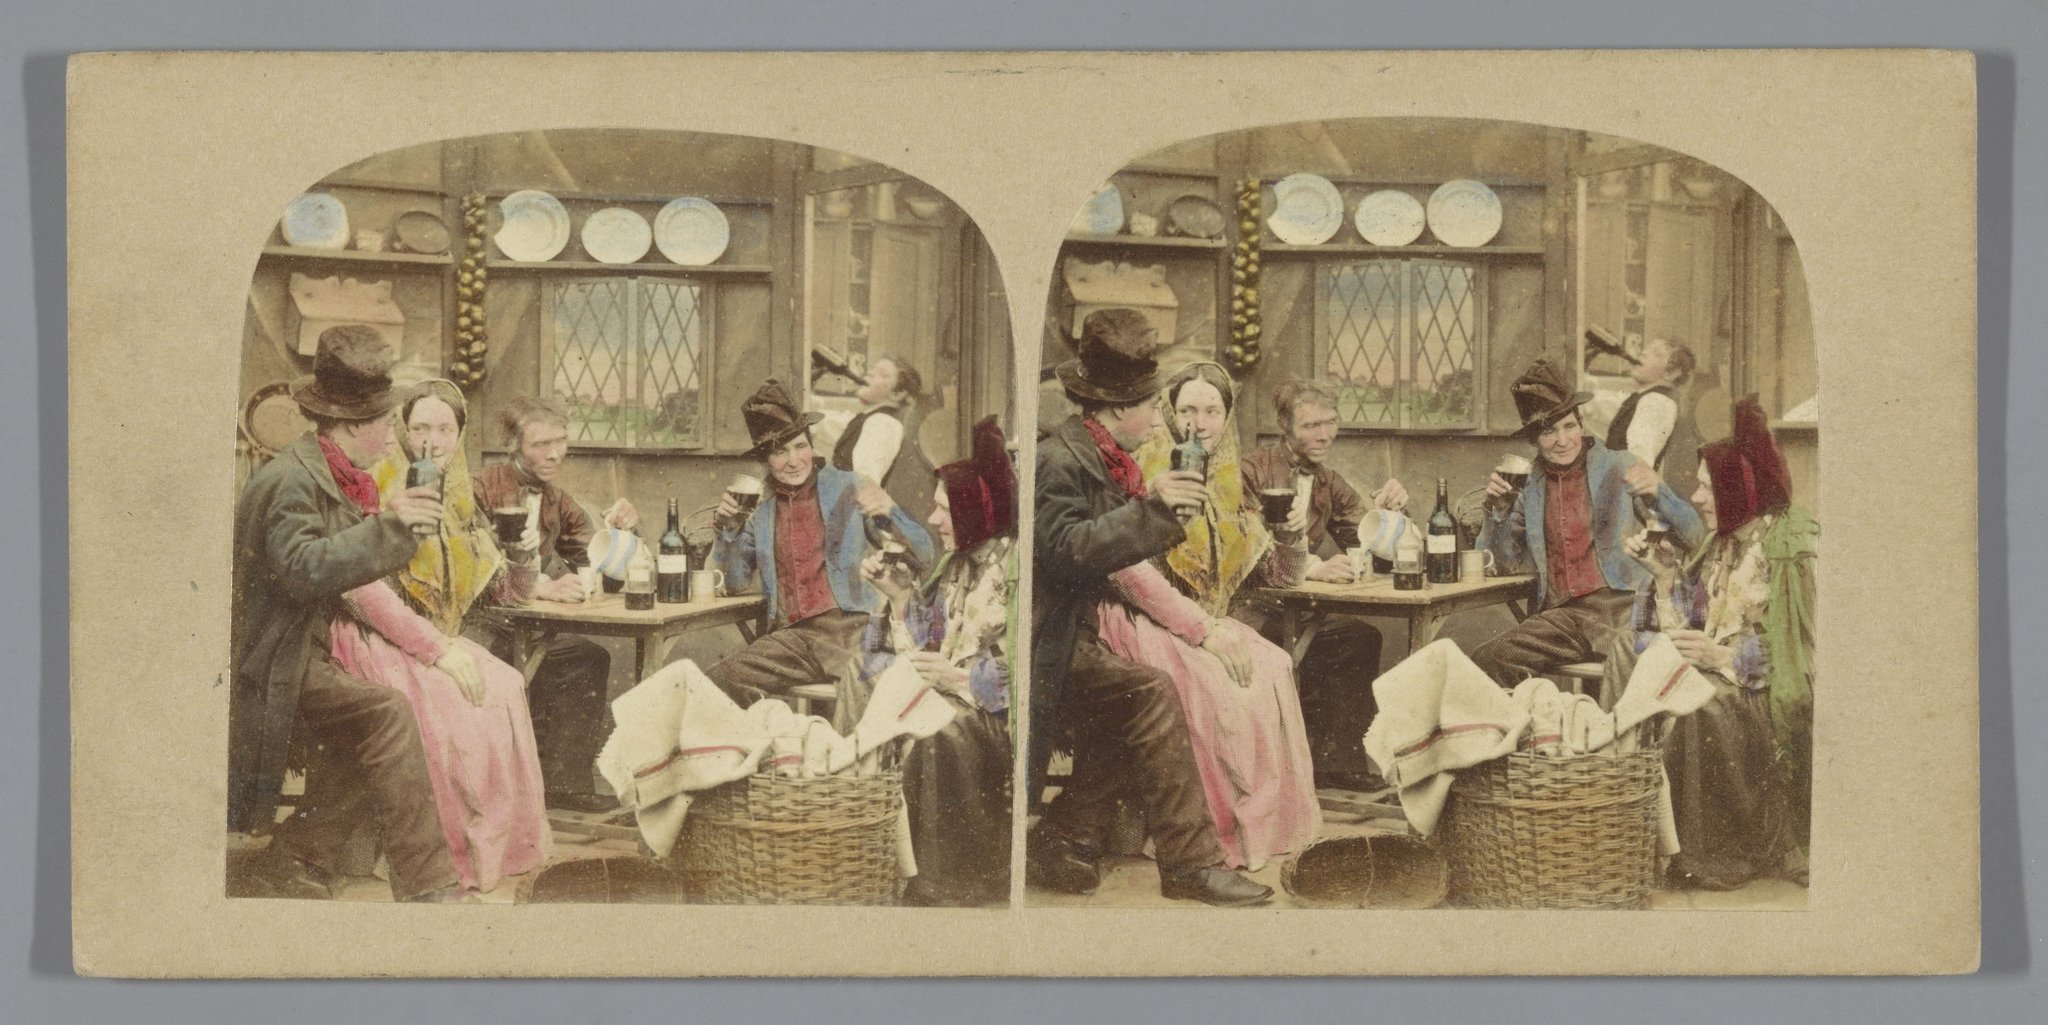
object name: stereograph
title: Drinkende mensen in een kroeg op St. Patrick's Day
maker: Anonymous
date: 1852-1863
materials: cardboard, paper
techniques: albumen print, hand coloring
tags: inn, coffee-house, public house, etc., periodic celebrations, popular feasts